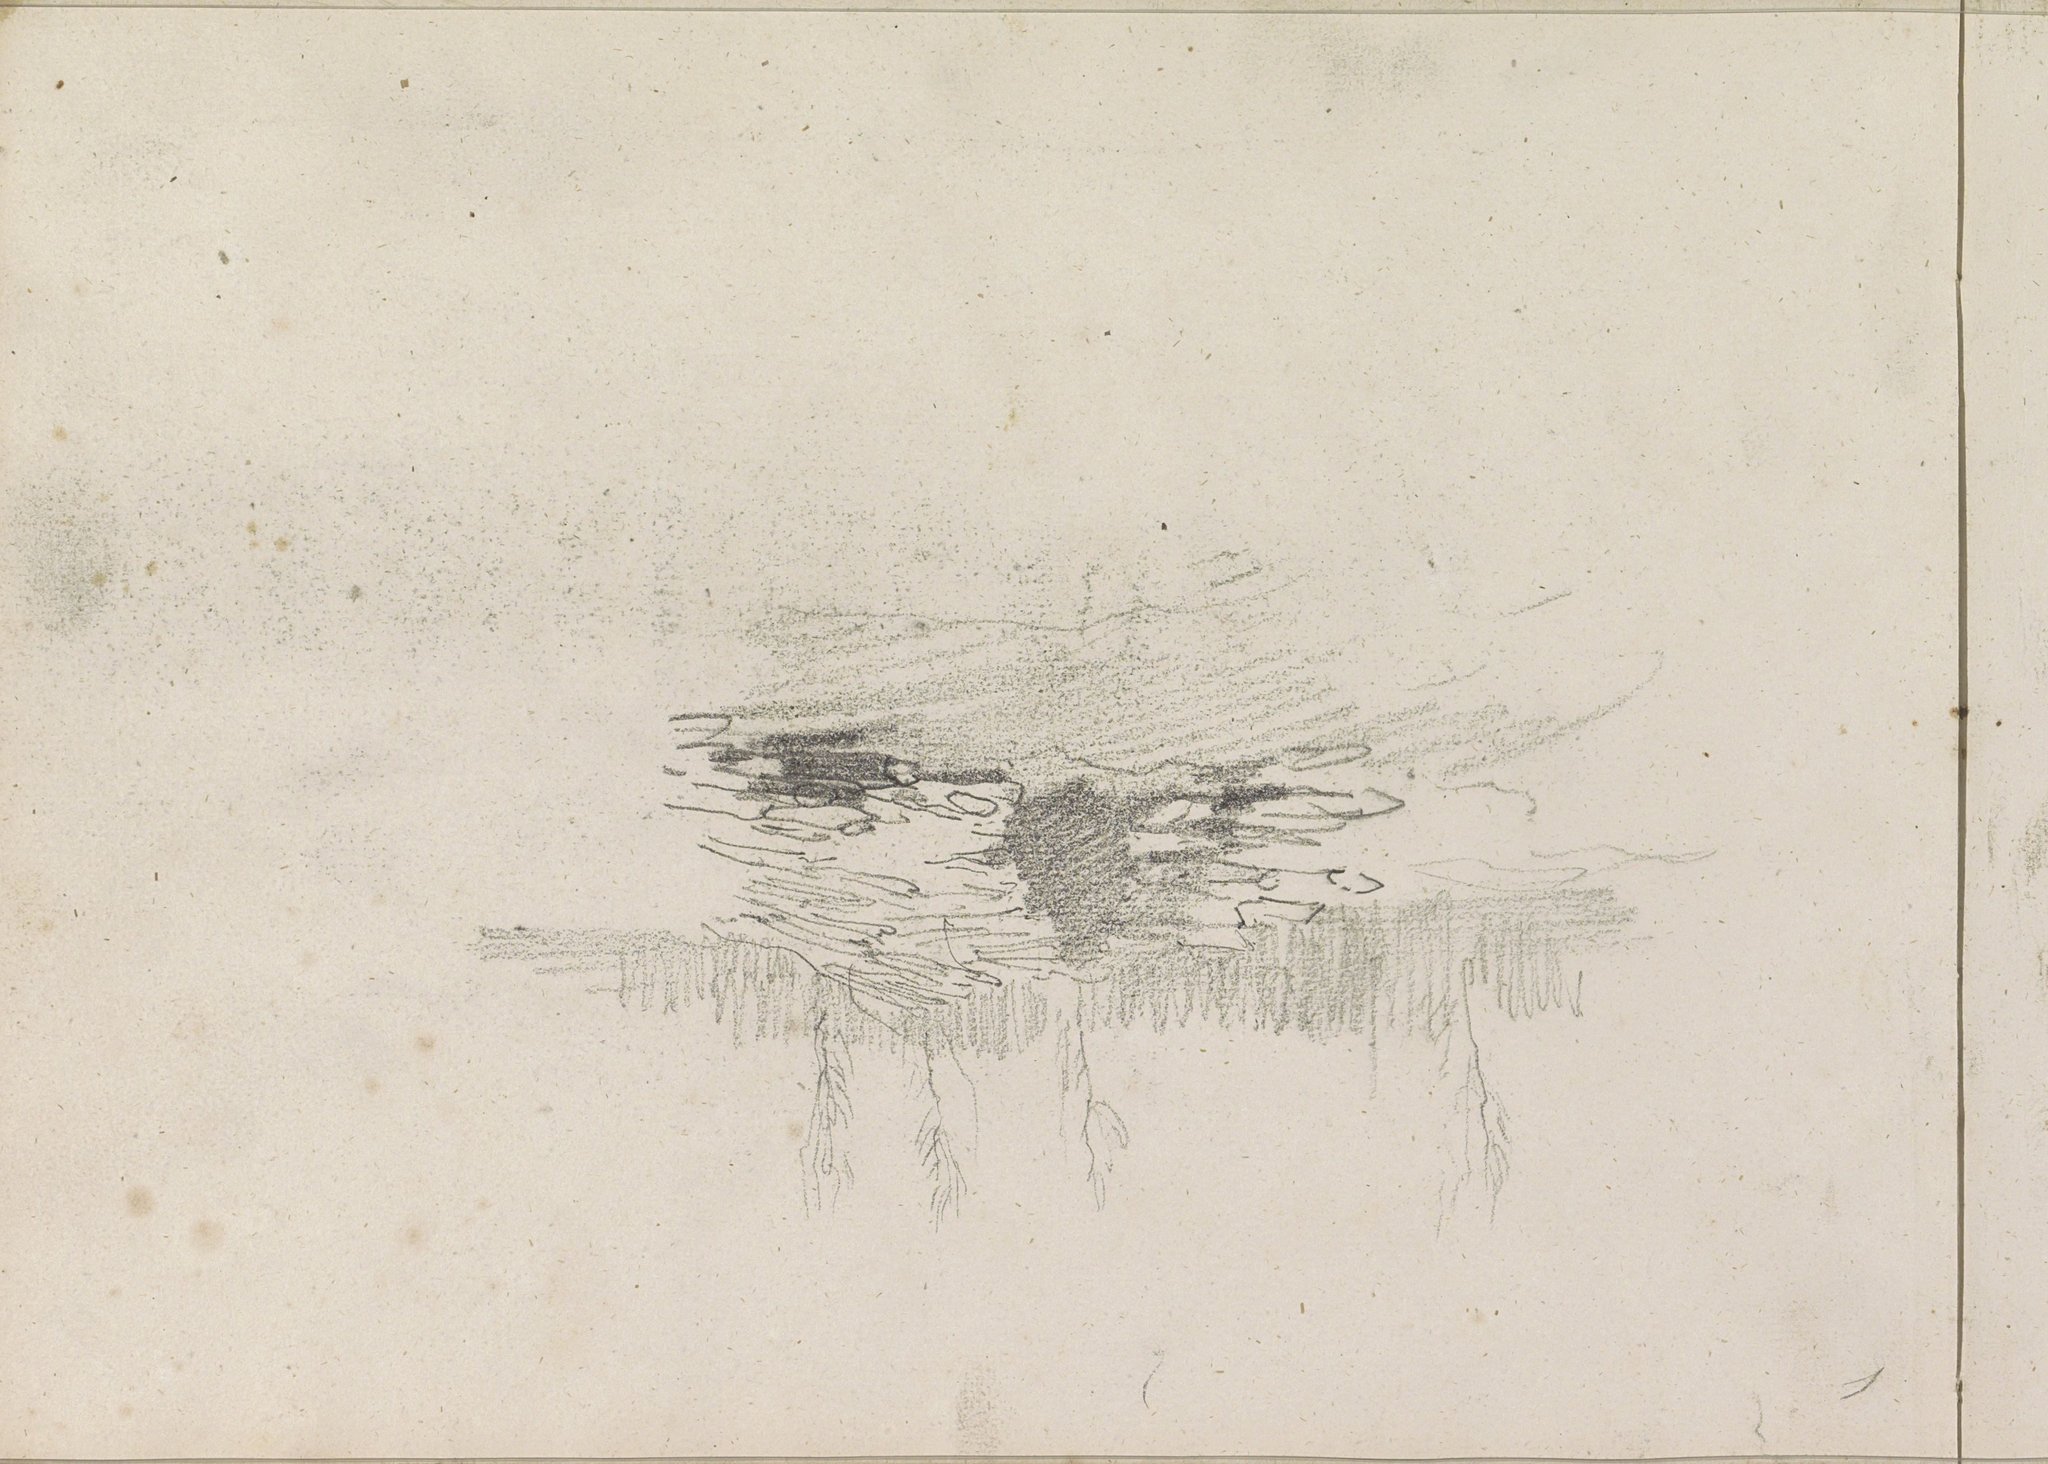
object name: sketchbook leaf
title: Stapel boomstammen op een veld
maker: anton mauve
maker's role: draughtsman, painter, print maker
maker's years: 1838-1888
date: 1848-1888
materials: paper, pencil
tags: trees (+ branch, stick)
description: Blad 25 verso uit een schetsboek met 34 bladen.